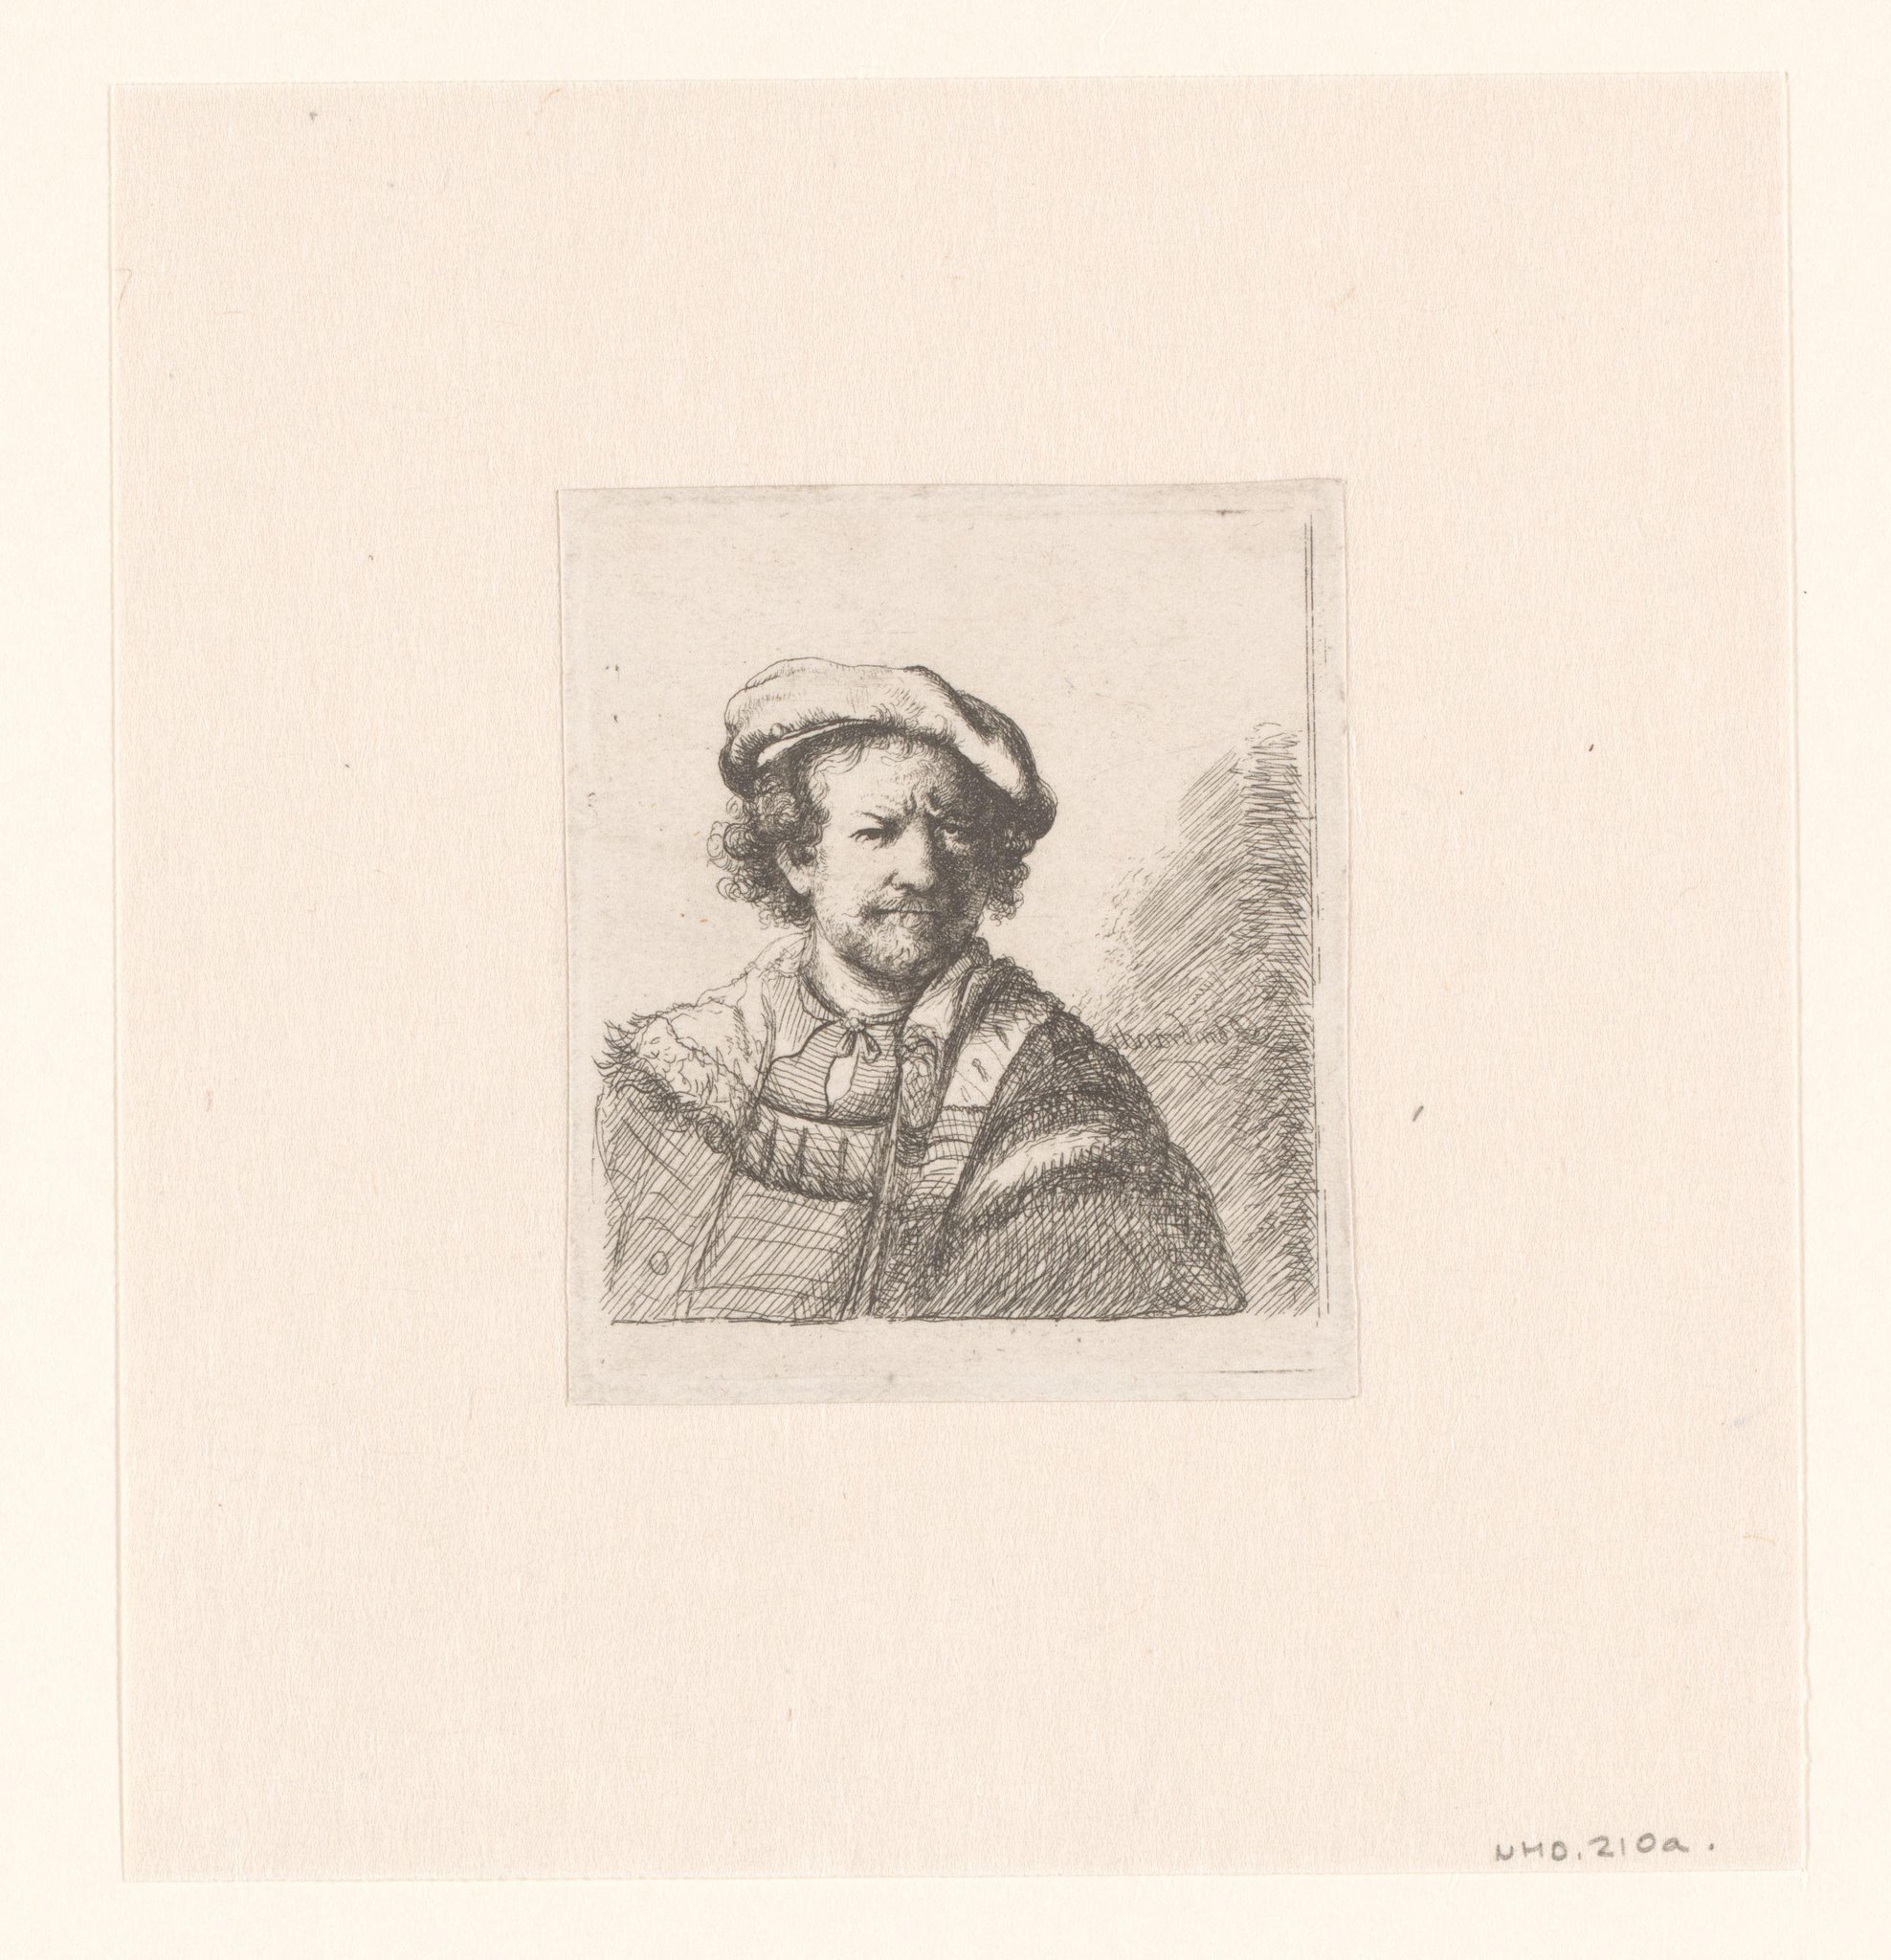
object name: print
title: Self-portrait in a flat cap and embroidered dress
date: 1753-1808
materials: paper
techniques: etching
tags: leiden, amsterdam, painter, draughtsman, rembrandt van rijn, portrait, self-portrait of graphic artist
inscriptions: collector's mark: Lugt 2228, collector's mark: Lugt 2760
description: Spiegelbeeldige kopie naar de gelijknamige prent van Rembrandt.